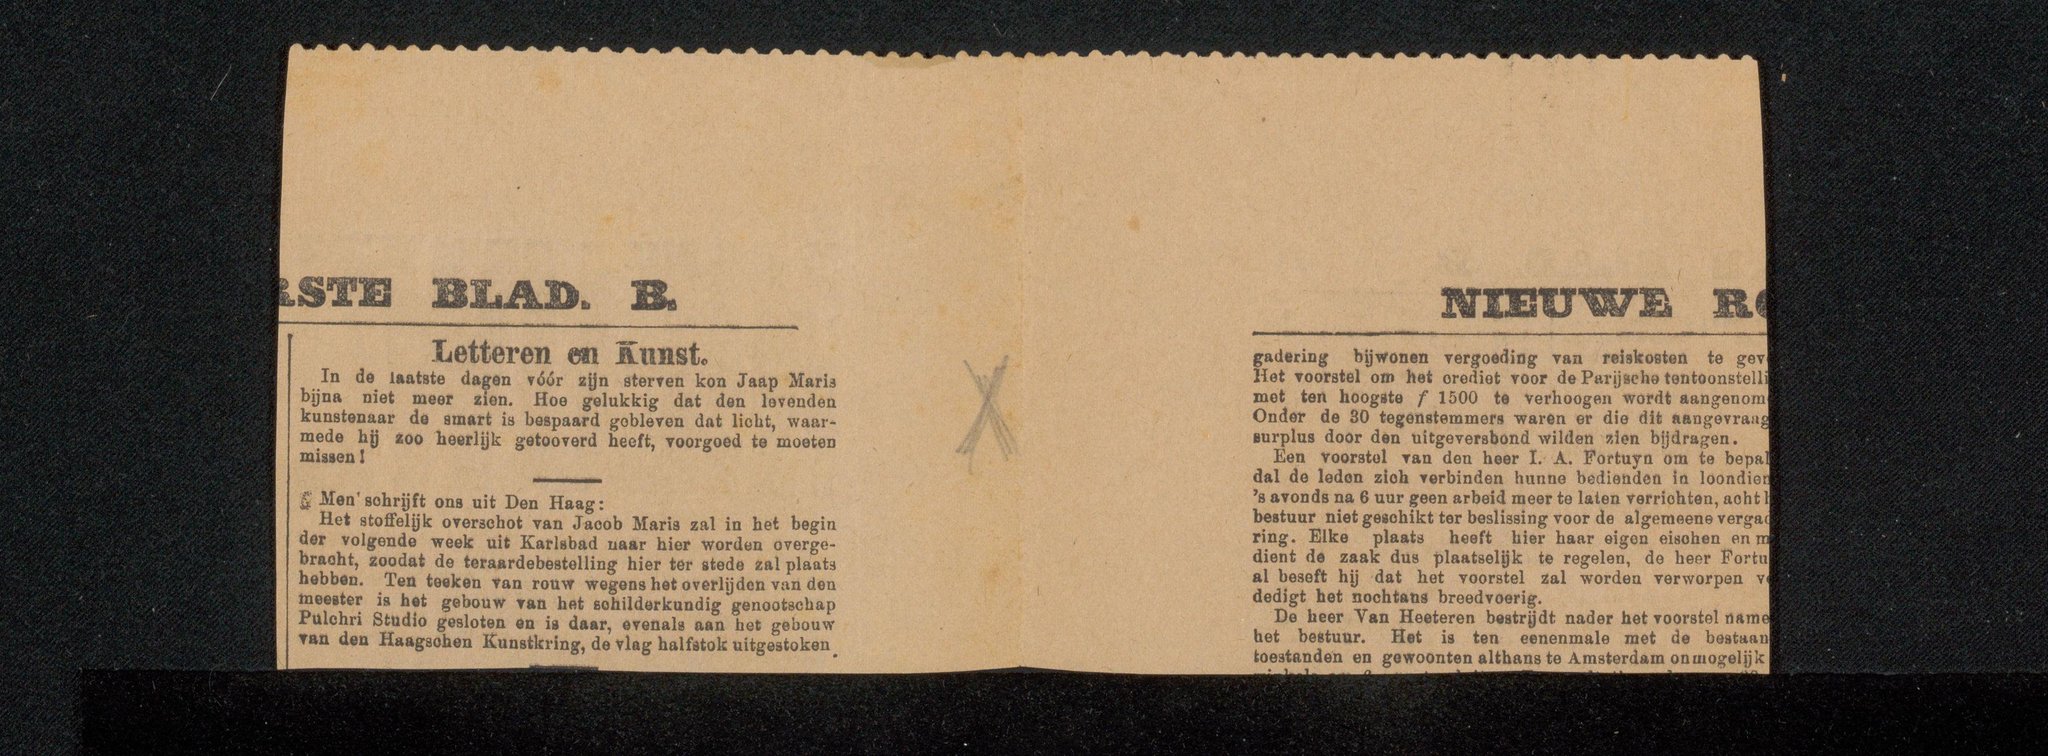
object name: newspaper clipping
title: Krantenknipsel uit archief Philip Zilcken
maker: Anonymous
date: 1899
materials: paper, ink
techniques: printing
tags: print maker, jacob maris, the hague, painter, draughtsman, philip zilcken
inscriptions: collector's mark: ‘RPK’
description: Krantenknipsel vormt samen met RP-D-1982-43-MARIS(JACOB)-DOC.4FA en RP-D-1982-43-MARIS(JACOB)-DOC.4FB een doorlopend artikel.